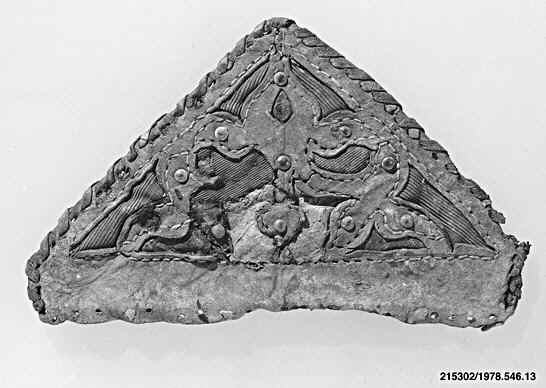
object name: flap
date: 1401-1500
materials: bronze, cotton, leather, paper, silk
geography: egypt